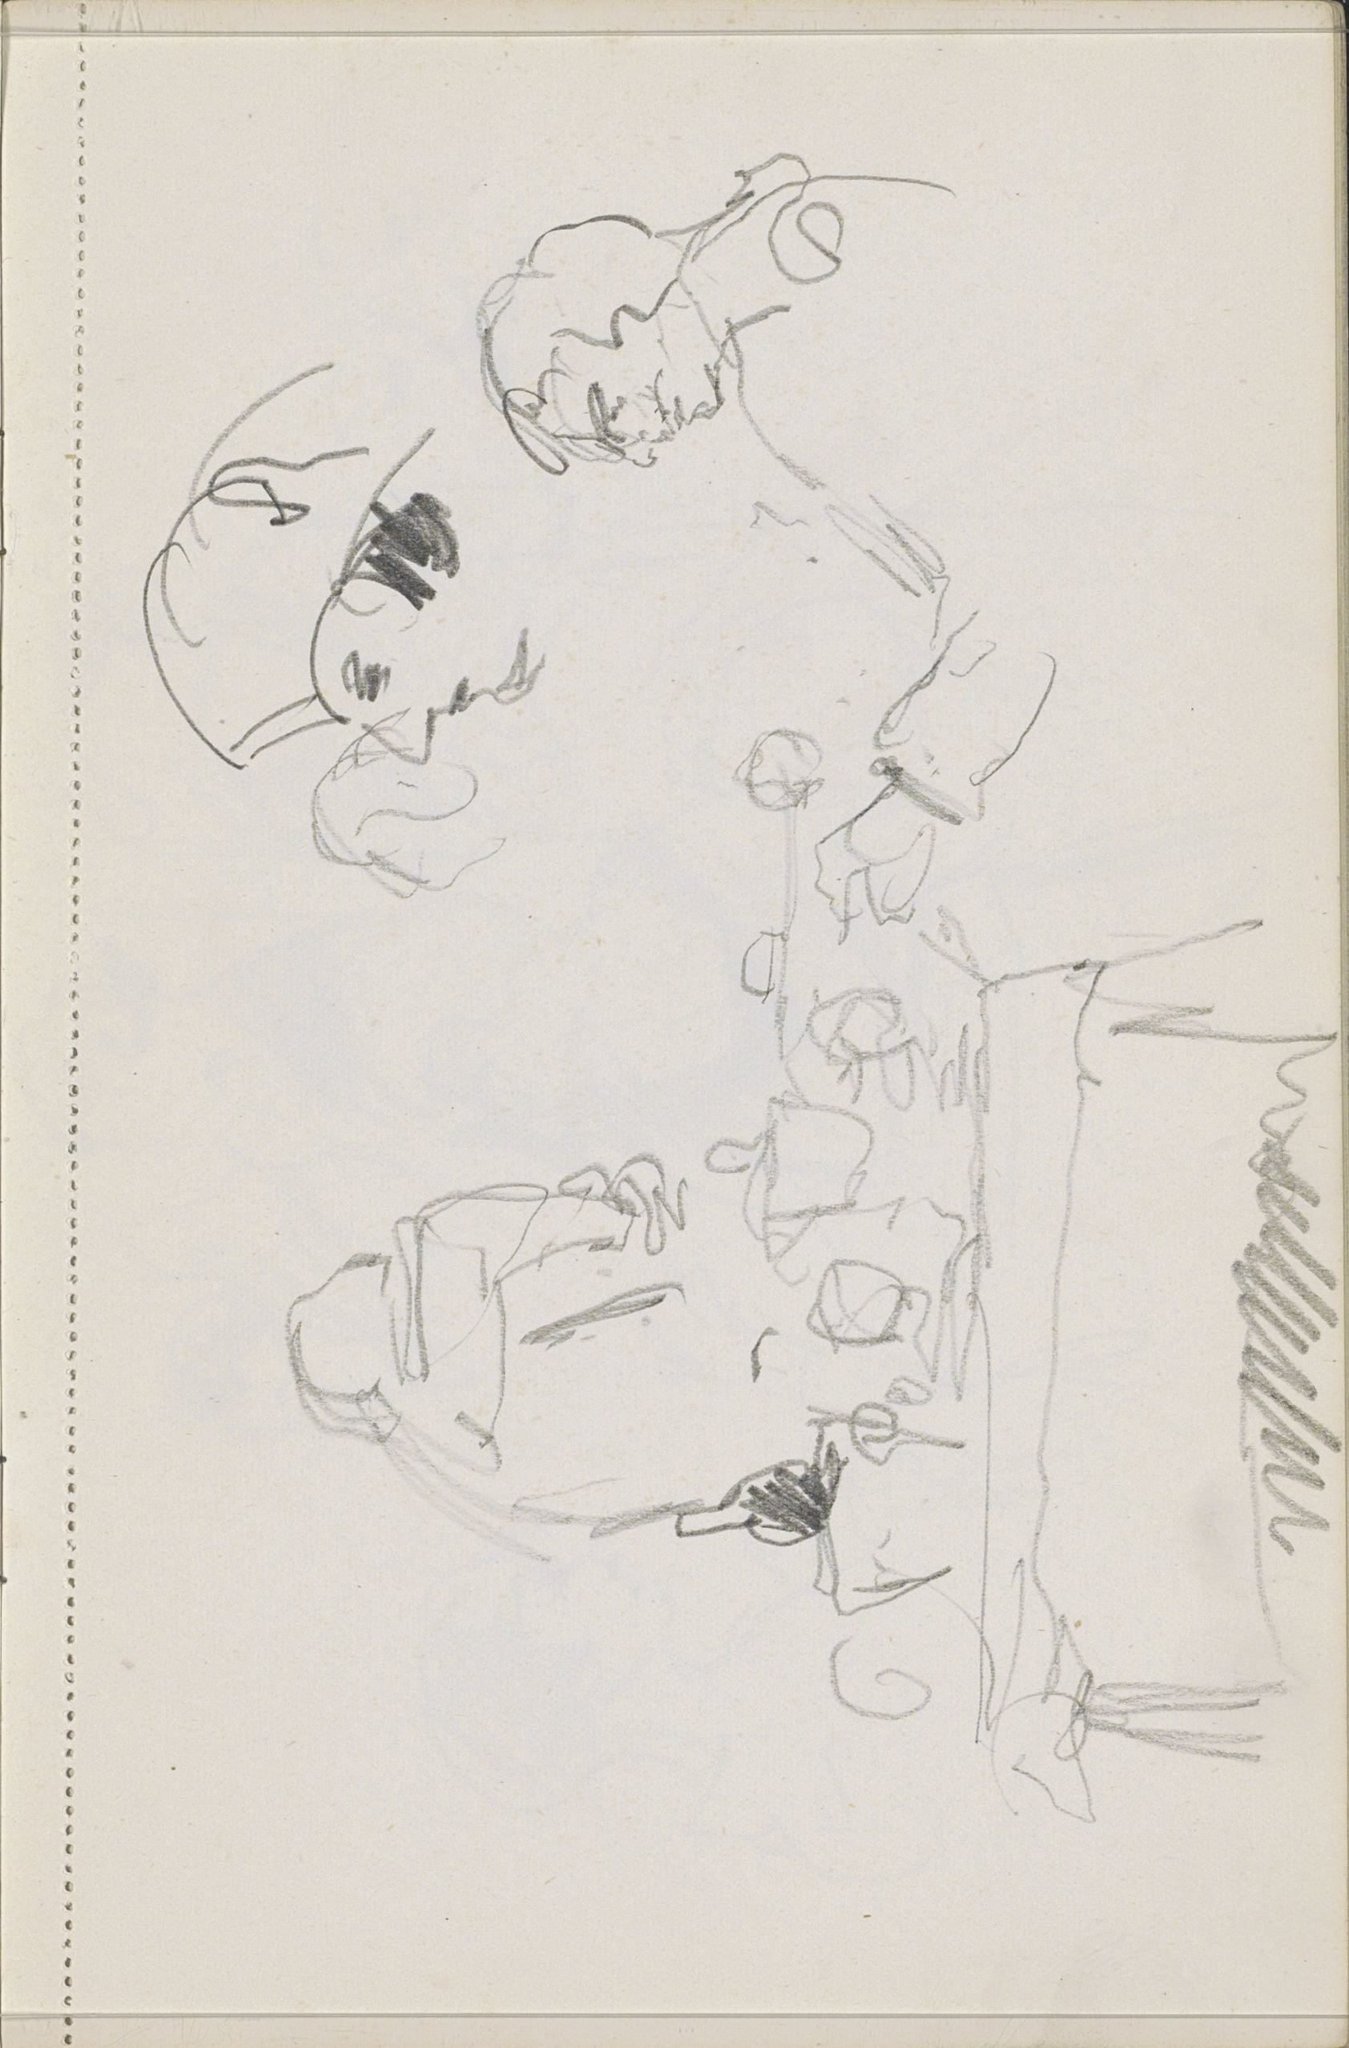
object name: sketchbook leaf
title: Figuur zittend aan een gedekte tafel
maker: cornelis vreedenburgh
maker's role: draughtsman, print maker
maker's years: 1880-1946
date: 1890-1946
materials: paper, pencil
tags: laid table: table-ware, table-decoration, etc.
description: Tevens een studie van en vrouwenkop met hoed. Blad 15 recto uit een schetsboek met 53 bladen.